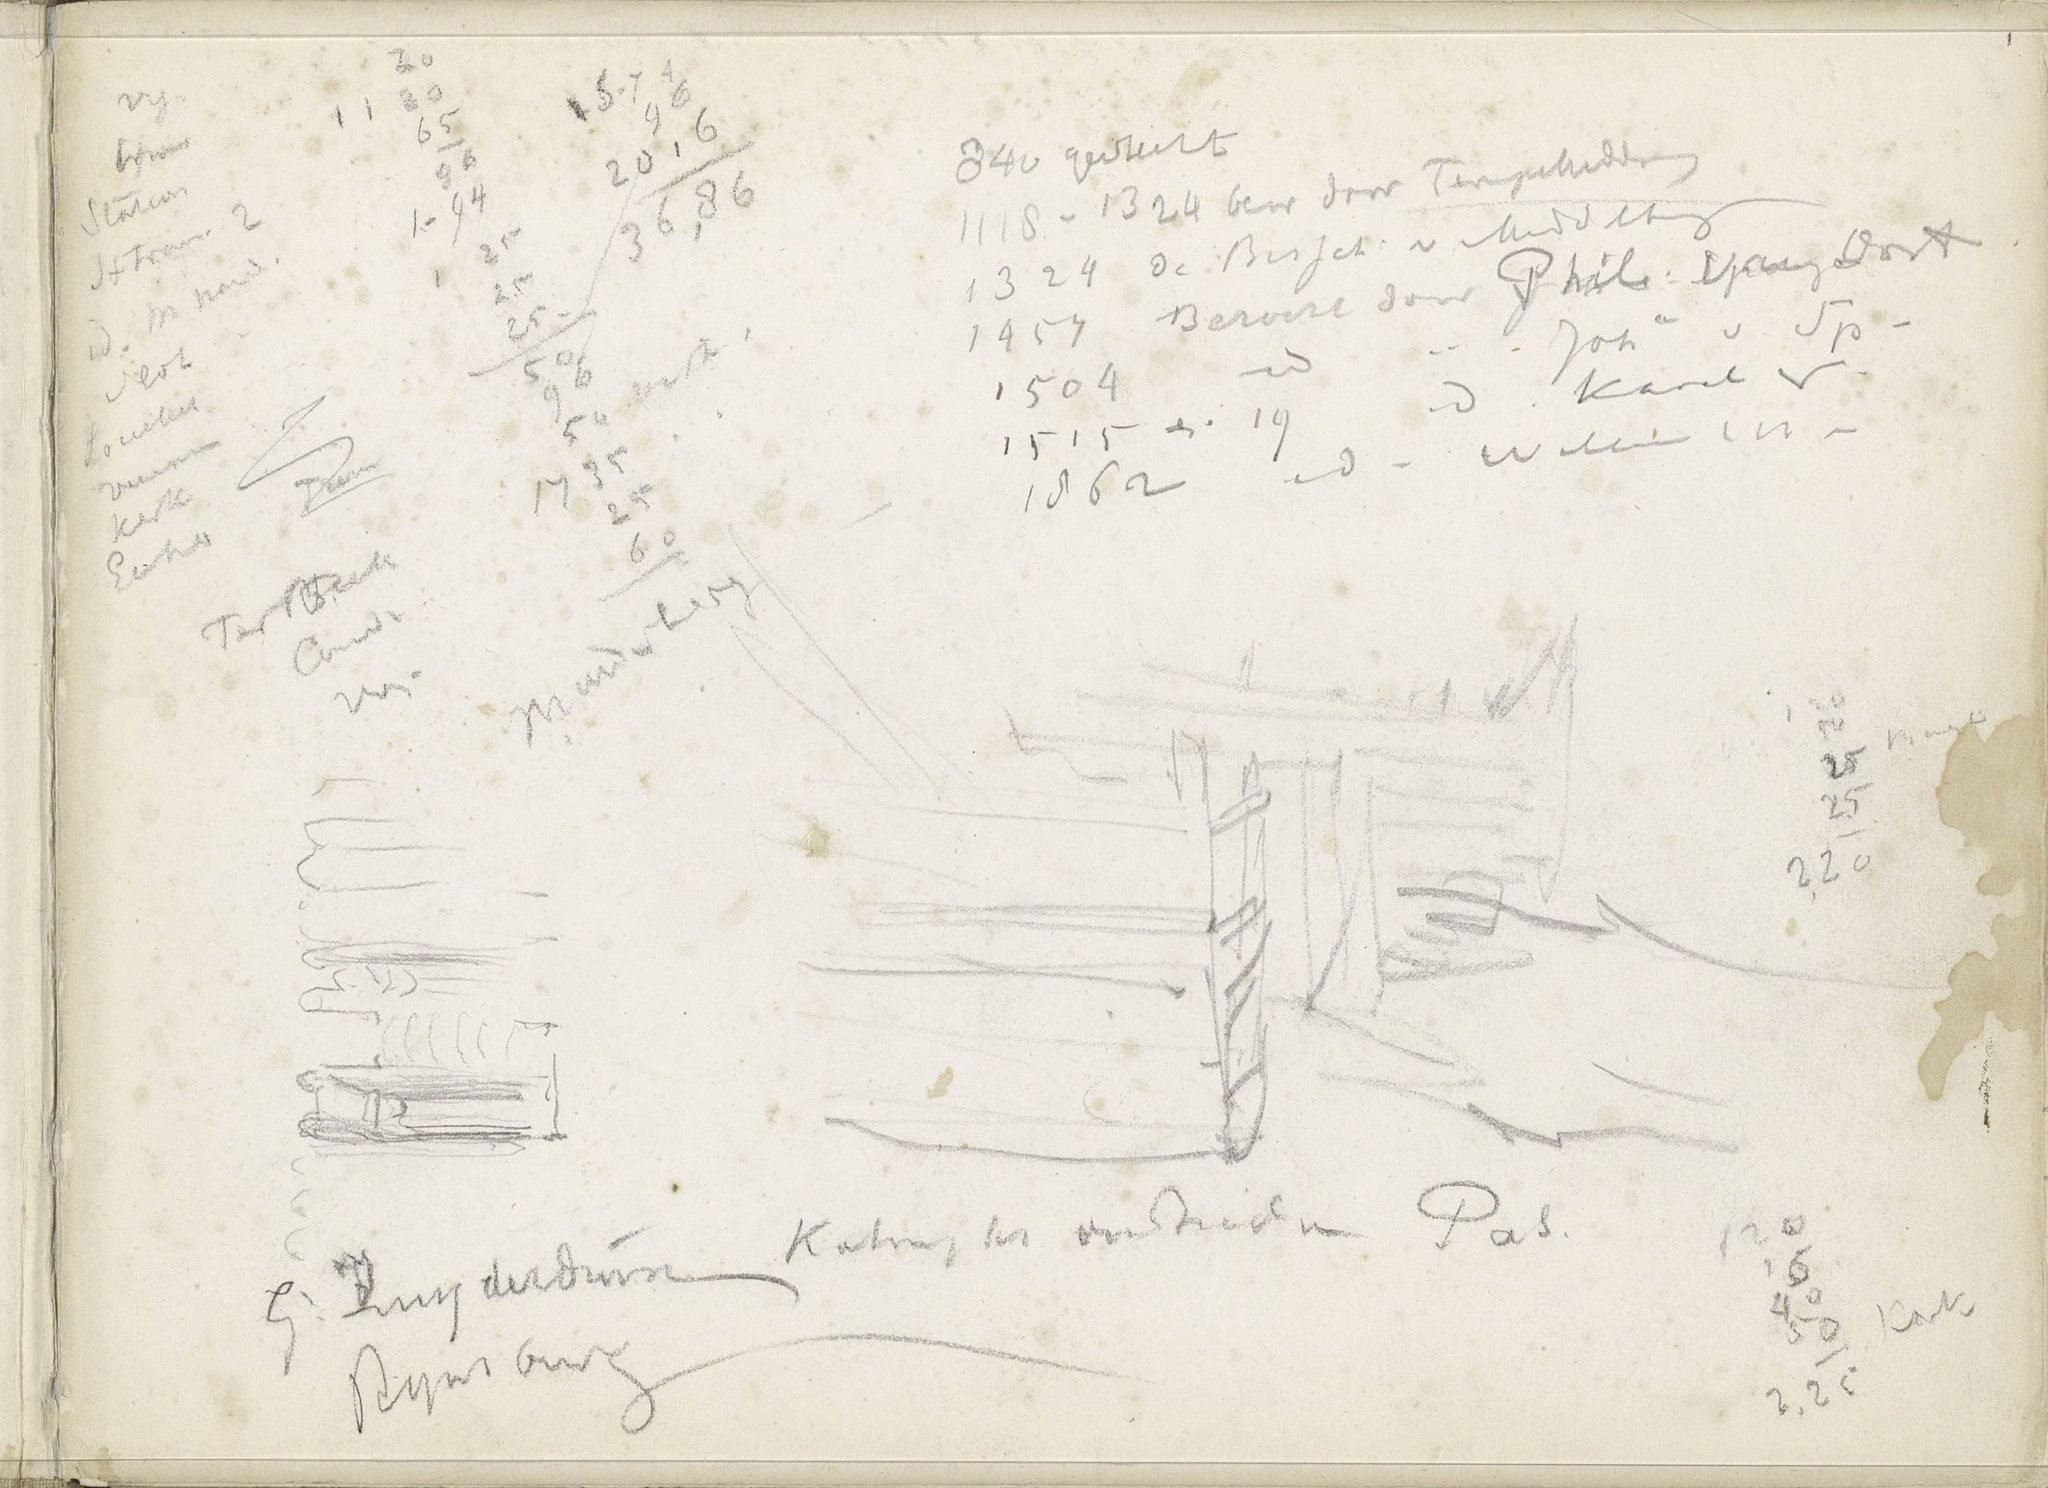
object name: sketchbook leaf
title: Studies, vermoedelijk een hek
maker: johannes bosboom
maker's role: draughtsman, painter, print maker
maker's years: 1817-1891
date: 1827-1891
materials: paper, pencil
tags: fence, wall, paling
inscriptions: annotation: ‘[...]’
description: Blad 1 recto uit een schetsboek met 13 bladen.